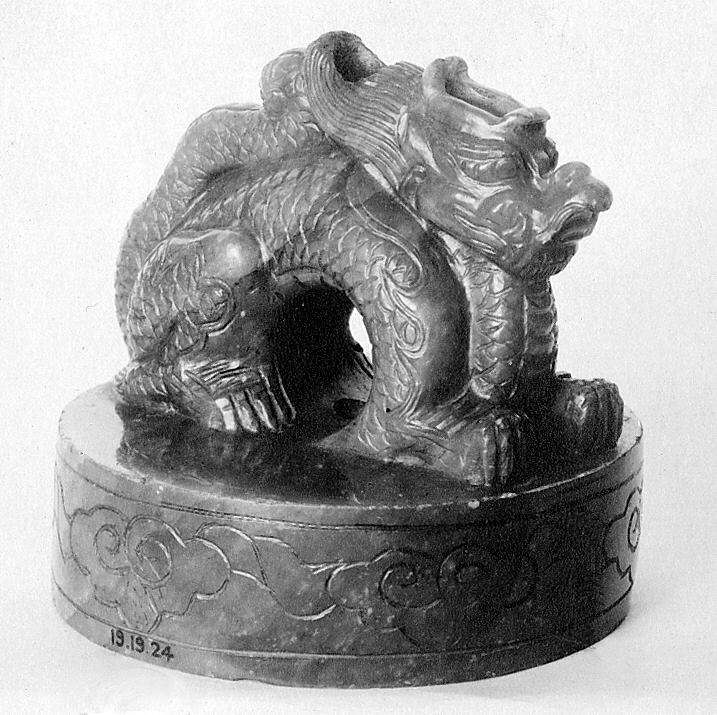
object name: seal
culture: chinese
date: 1271-1368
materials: jade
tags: mythical creatures